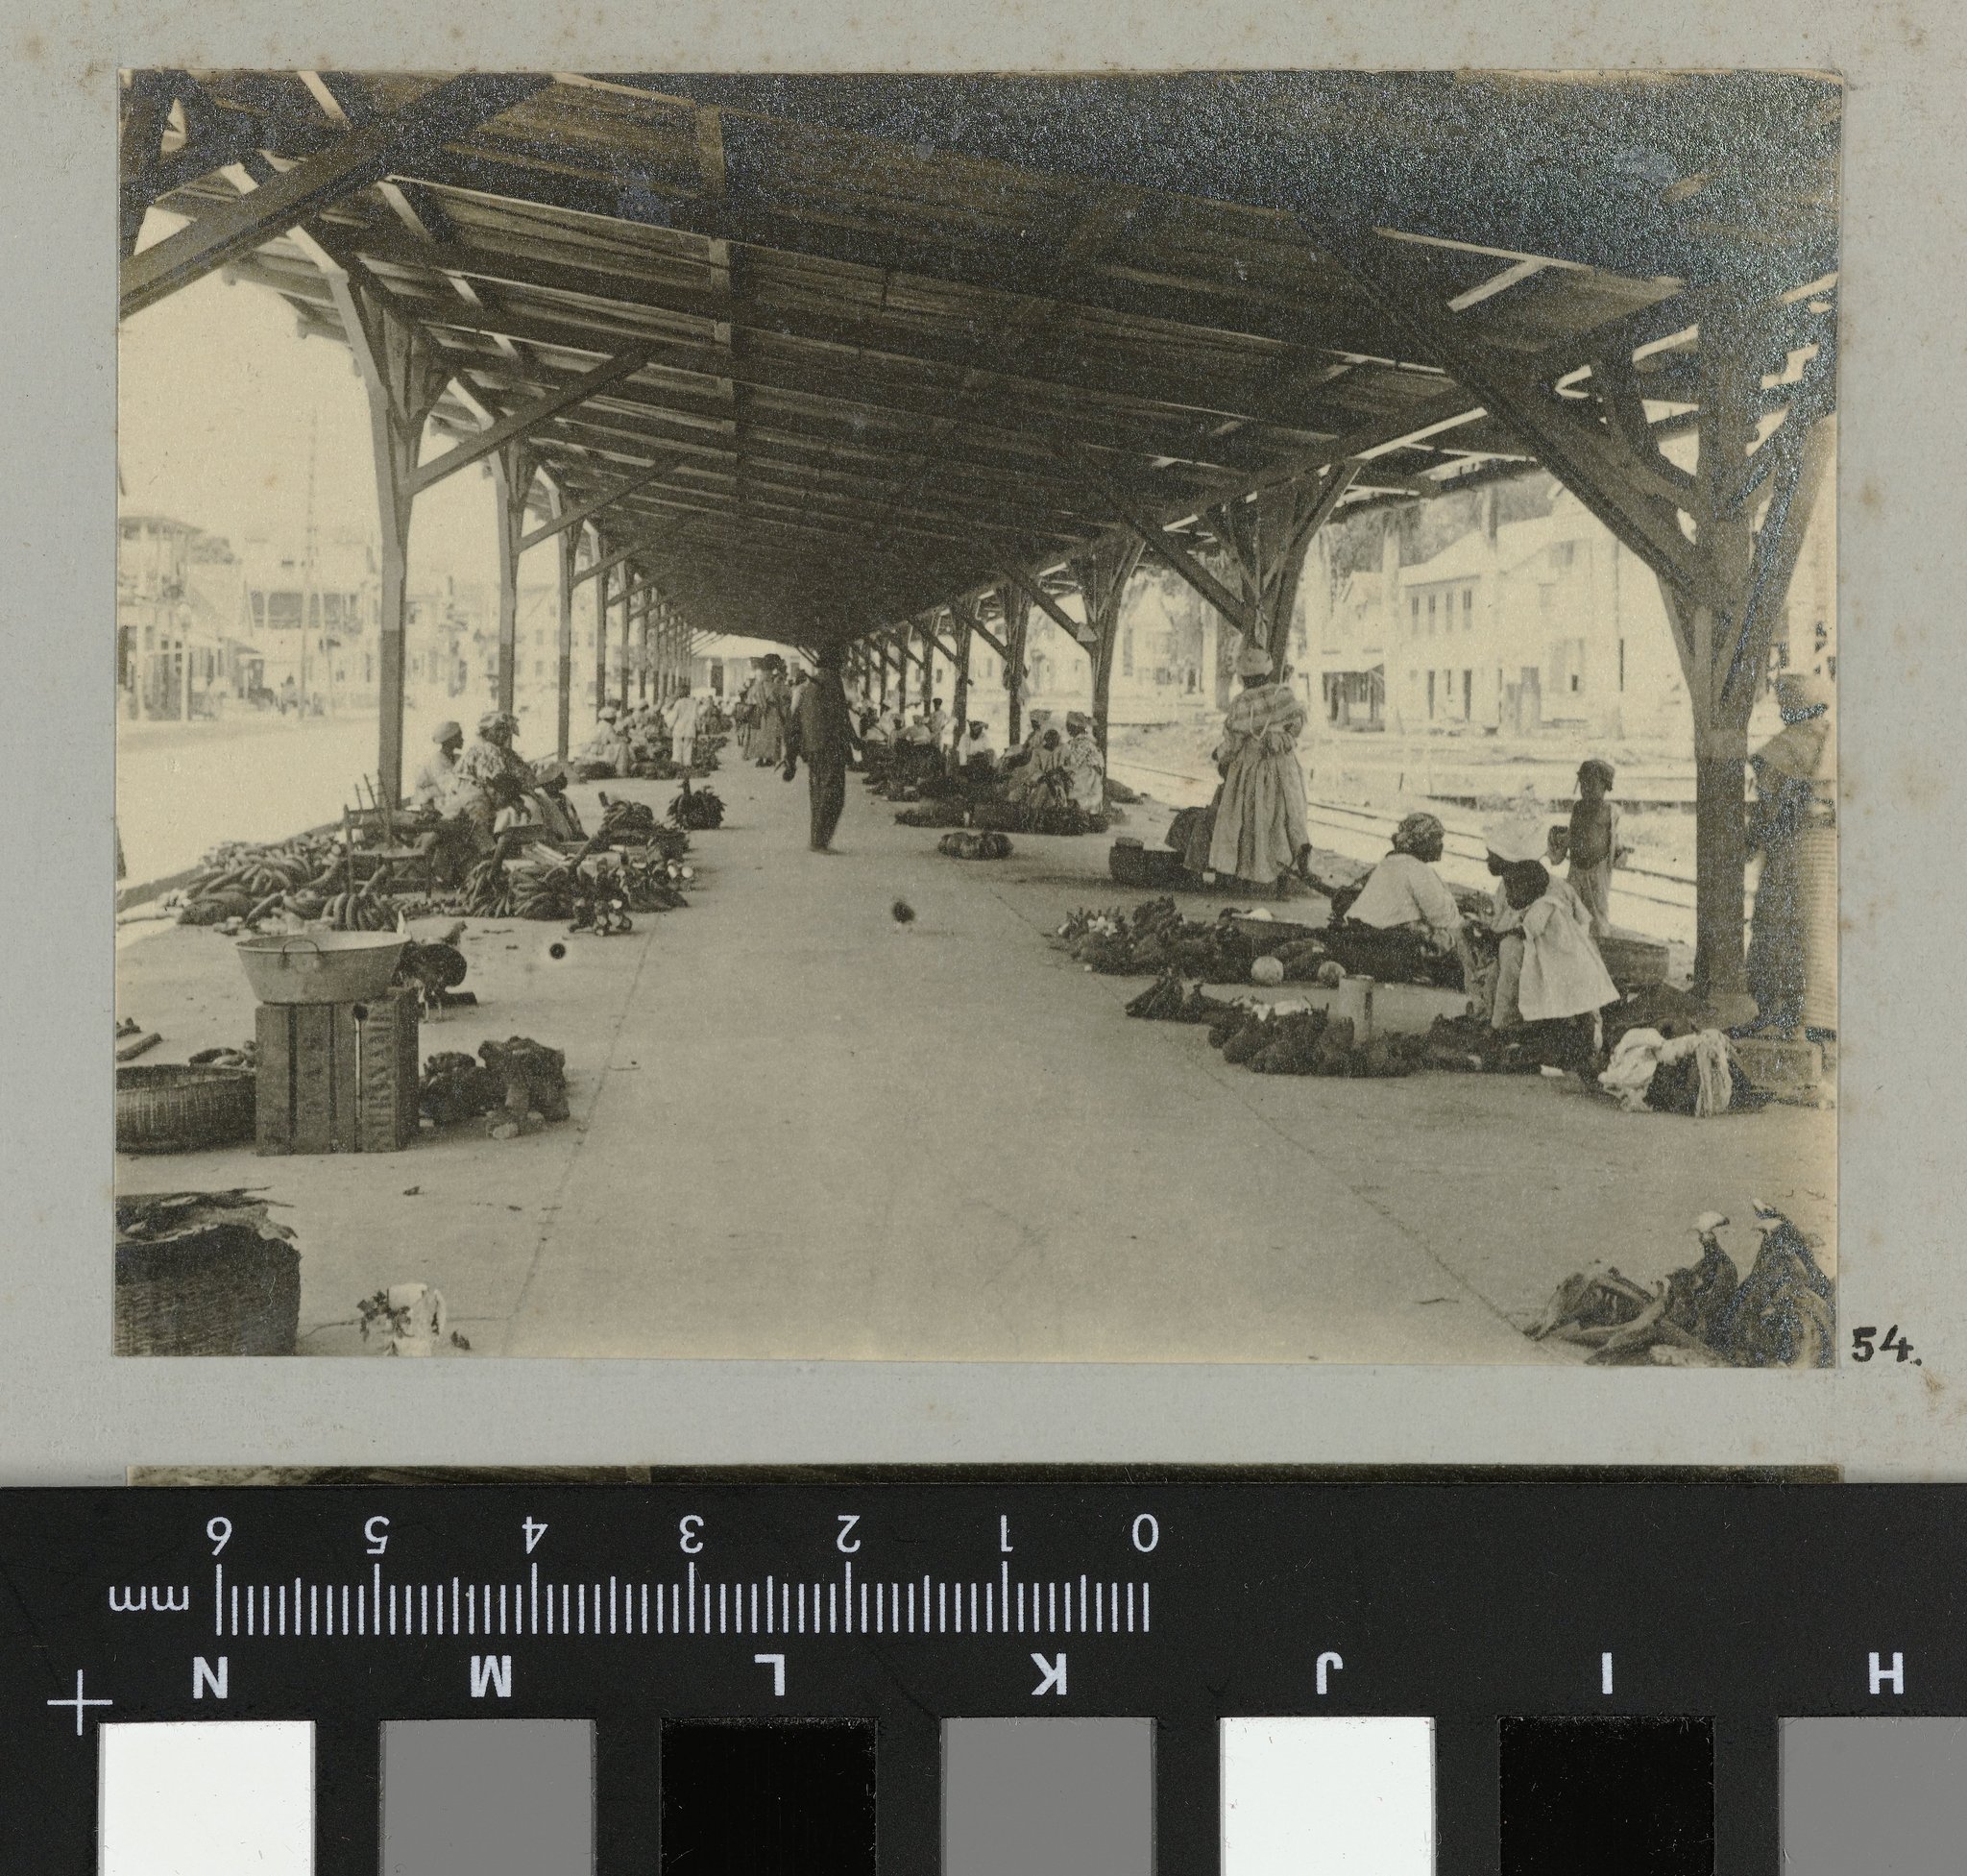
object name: photograph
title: Overdekte markt aan Heiligenweg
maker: hendrik doijer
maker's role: engineer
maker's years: 1863-1925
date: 1903-1910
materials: photographic support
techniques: gelatin silver print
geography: suriname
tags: suriname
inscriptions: inscription: ‘54. / Overdekte markt aan Heiligenweg.’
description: Gezicht in de overdekte markt aan de Heiligenweg te Paramaribo. Verkopers zitten met hun waar op de grond. Onderdeel van het fotoalbum Souvenir de Voyage (deel 2), over het leven van de familie Doijer in en rond de plantage Ma Retraite in Suriname in de jaren 1903-1910.